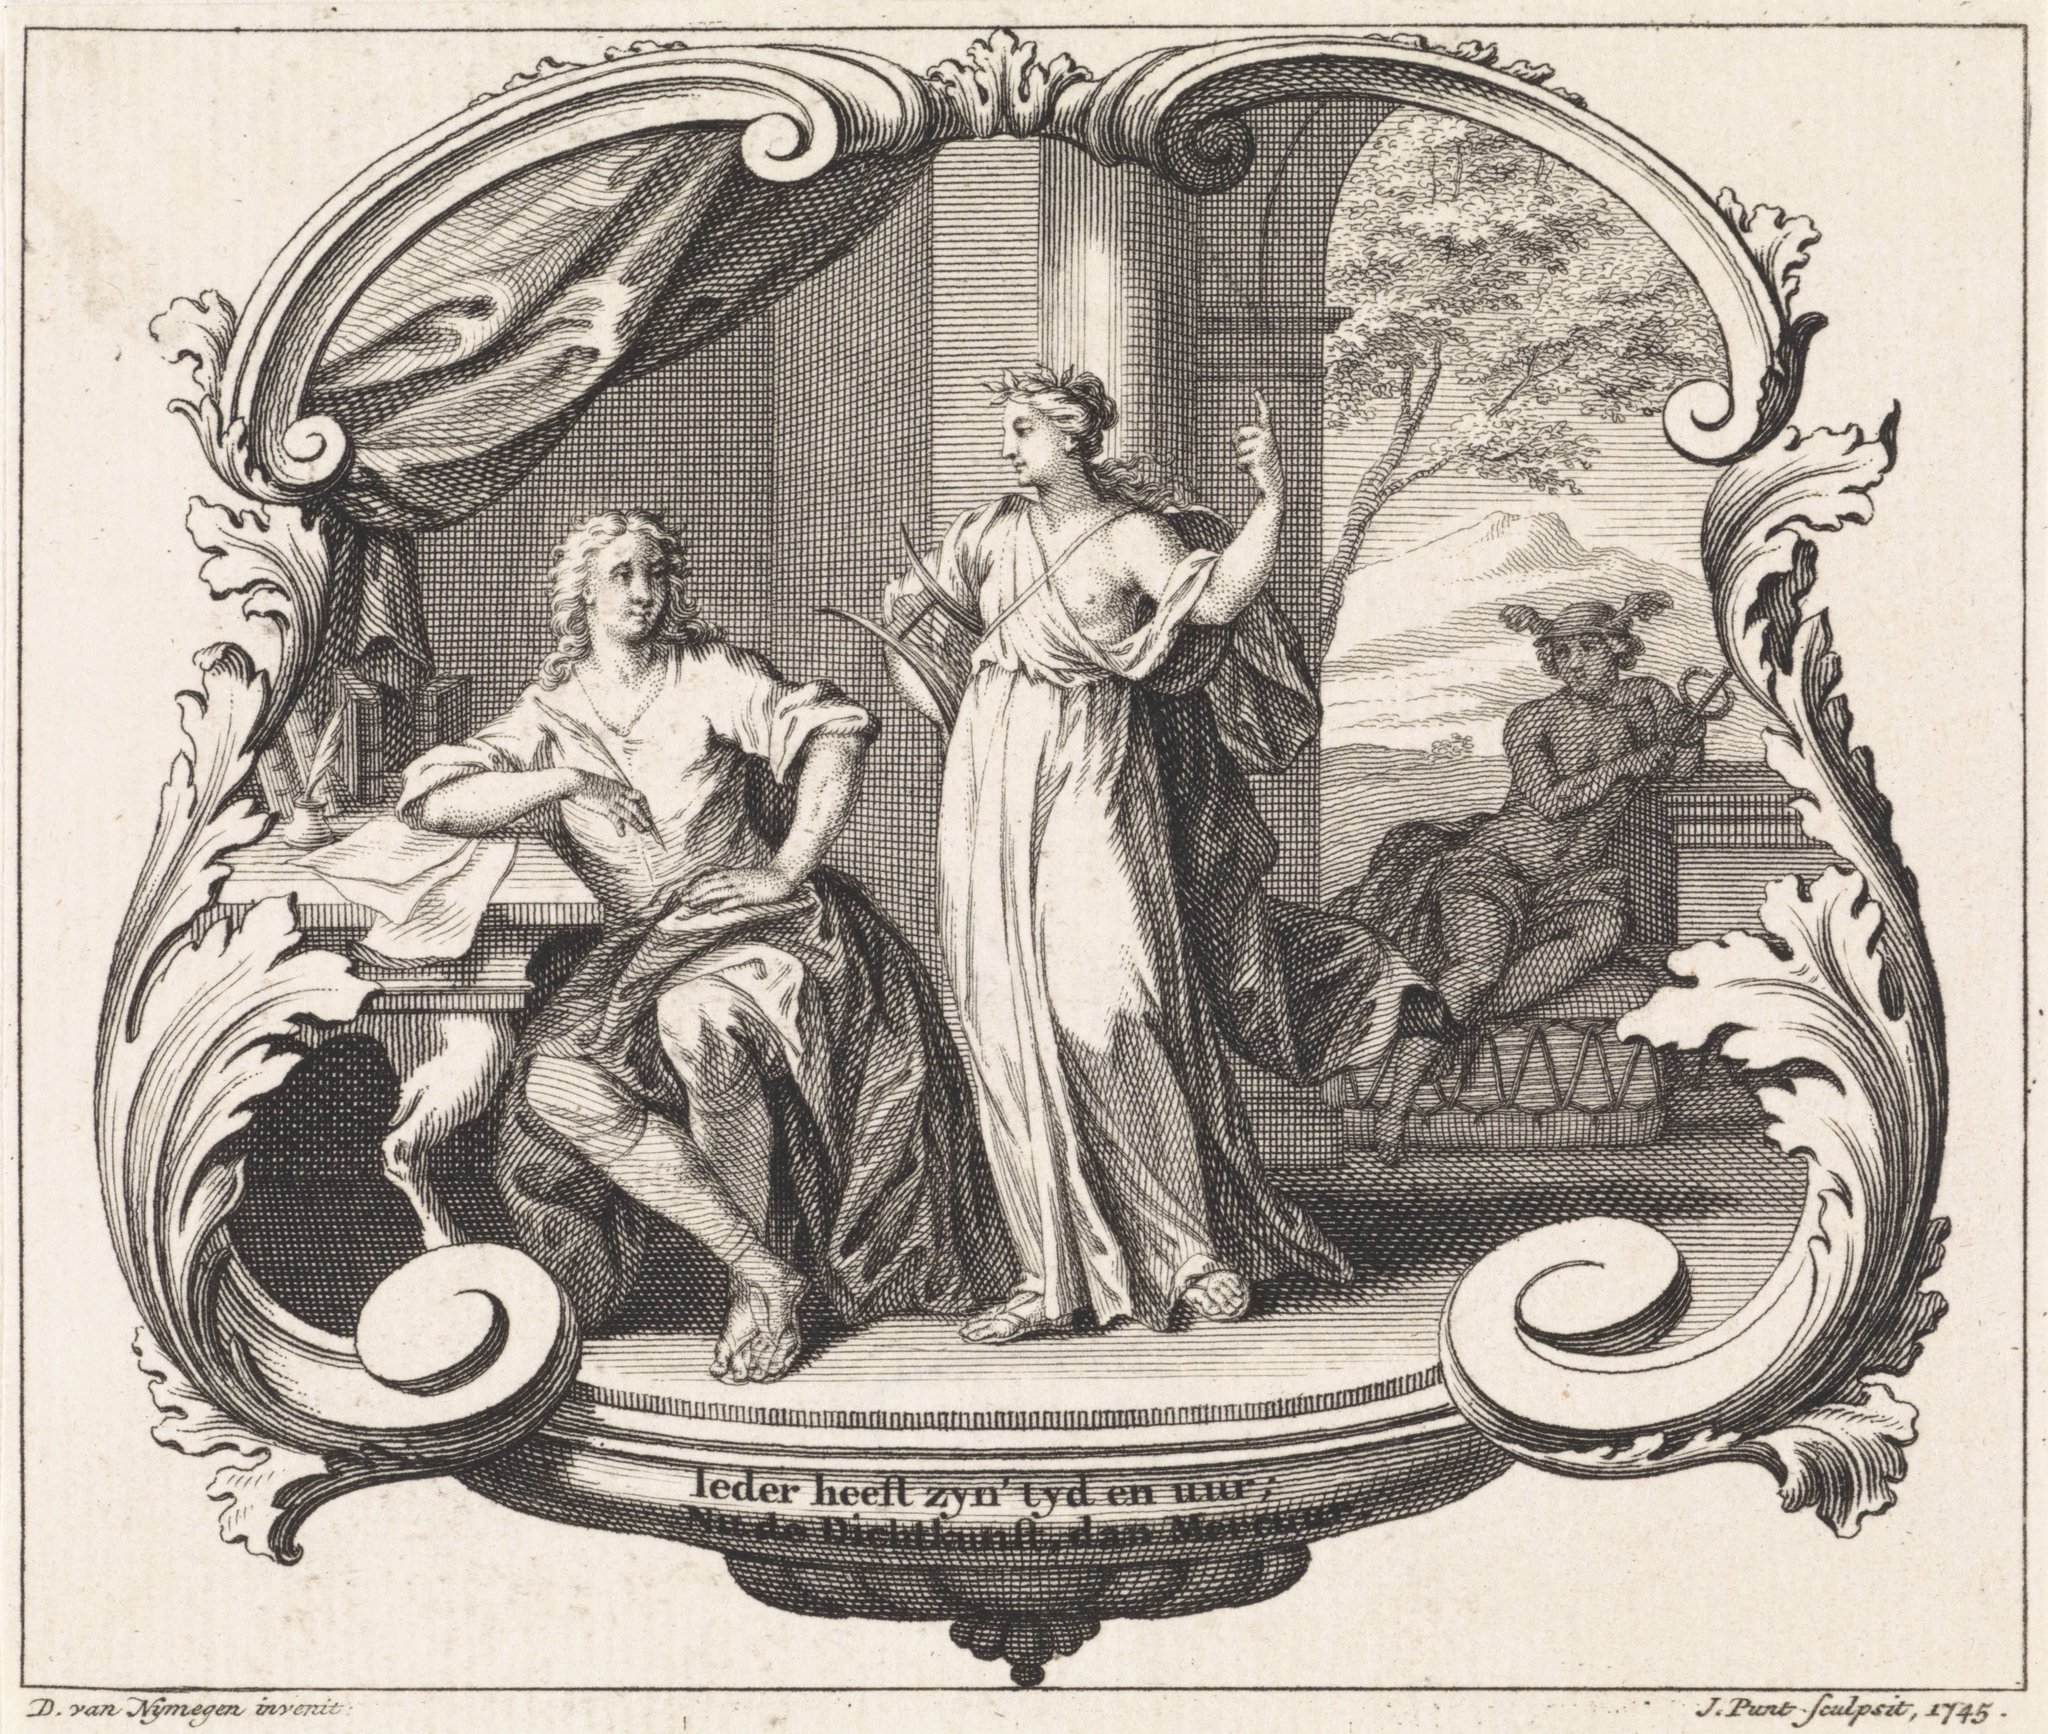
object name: print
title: Ieder heeft zyn 'tyd en uur; Nu de Dichtkunst, dan Mercuur.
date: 1745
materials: paper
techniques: engraving, etching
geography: amsterdam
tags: writing-table, writing-desk, (story of) mercury (hermes), symbolic representations, allegories and emblems ~ poetry; 'poesia' (ripa)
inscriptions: collector's mark: Lugt 2228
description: Poëzie spreekt met opgeheven hand tegen een man die achter zijn bureau aan het schrijven is. Op de achtergrond kijkt Mercurius toe.